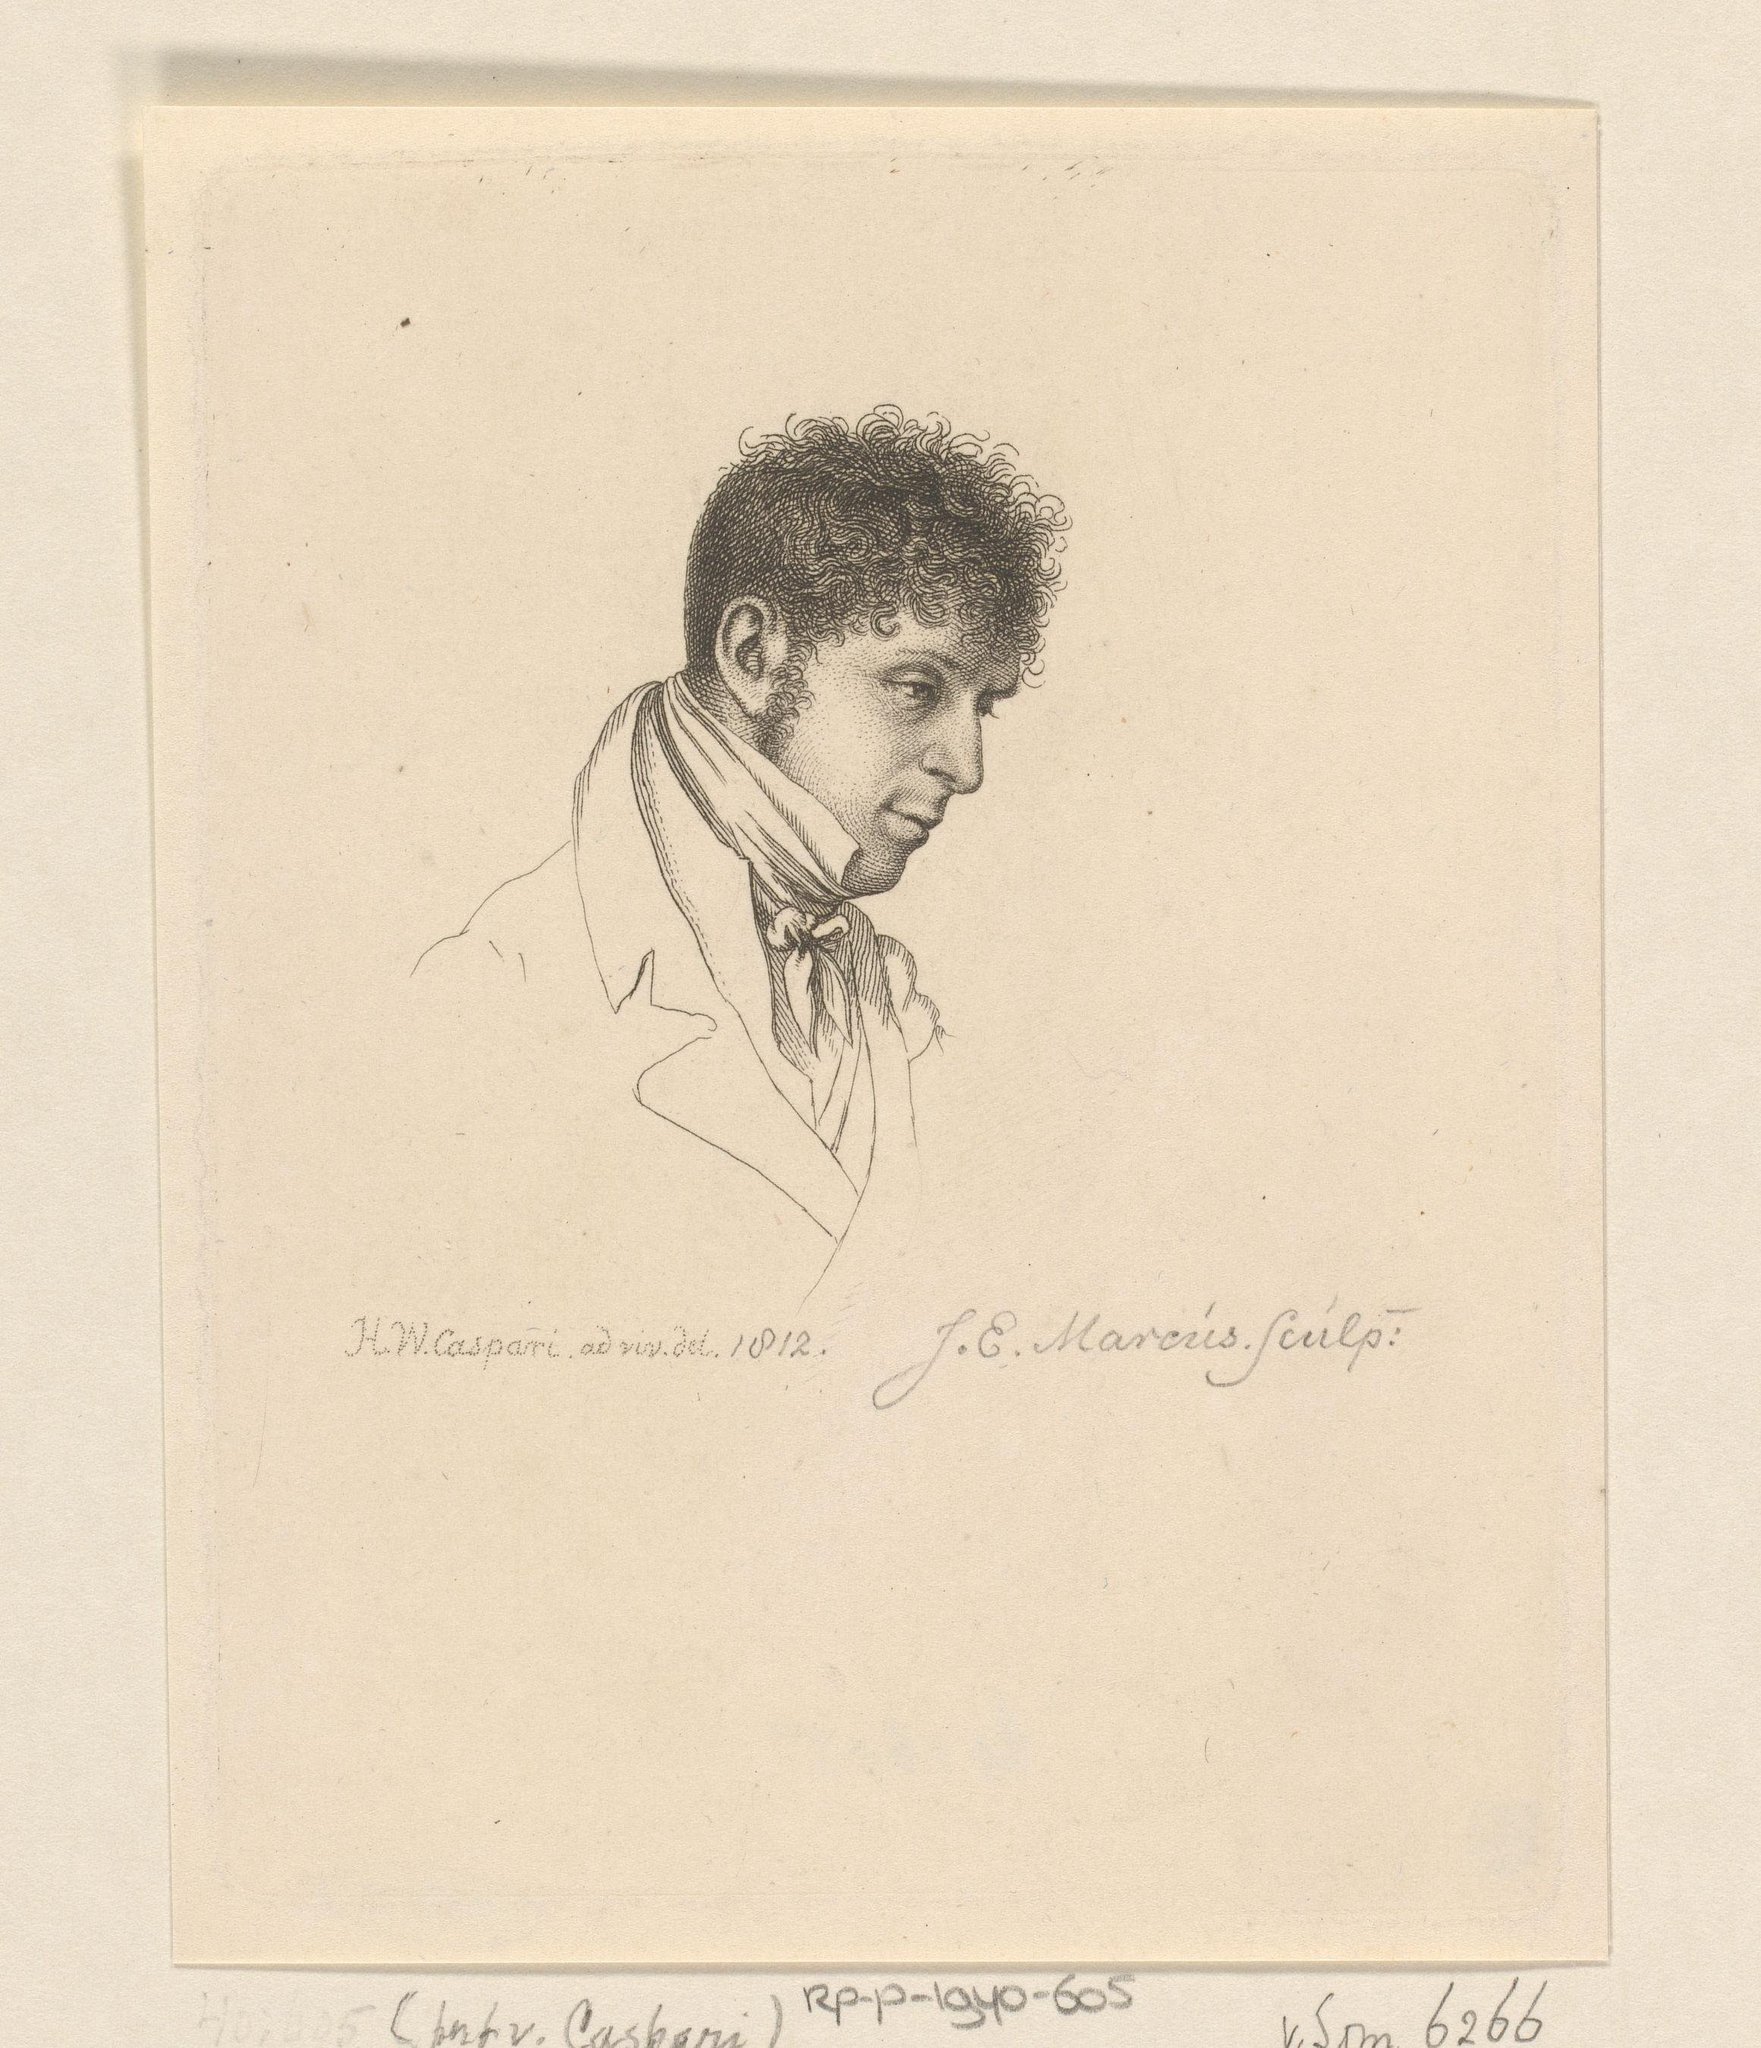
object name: print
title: Studie-prentwerk / Etudes gravées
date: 1812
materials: paper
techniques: etching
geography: amsterdam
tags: amsterdam, abraham lion zeelander, engraver, etcher, historical persons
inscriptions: inscription: ‘J.E. Marcús. sculp:’, collector's mark: Lugt 2760, collector's mark: Lugt 2228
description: Latere staat gebruikt voor de serie Studie-prentwerk / Etudes gravées. De prenten verschenen eerst maandelijks tussen november 1807 en juli 1816. Later gebundeld uitgegeven als: Studie-prentwerk/ Etudes gravées, ca. 1817. In 1834 volgde nog een heruitgave.